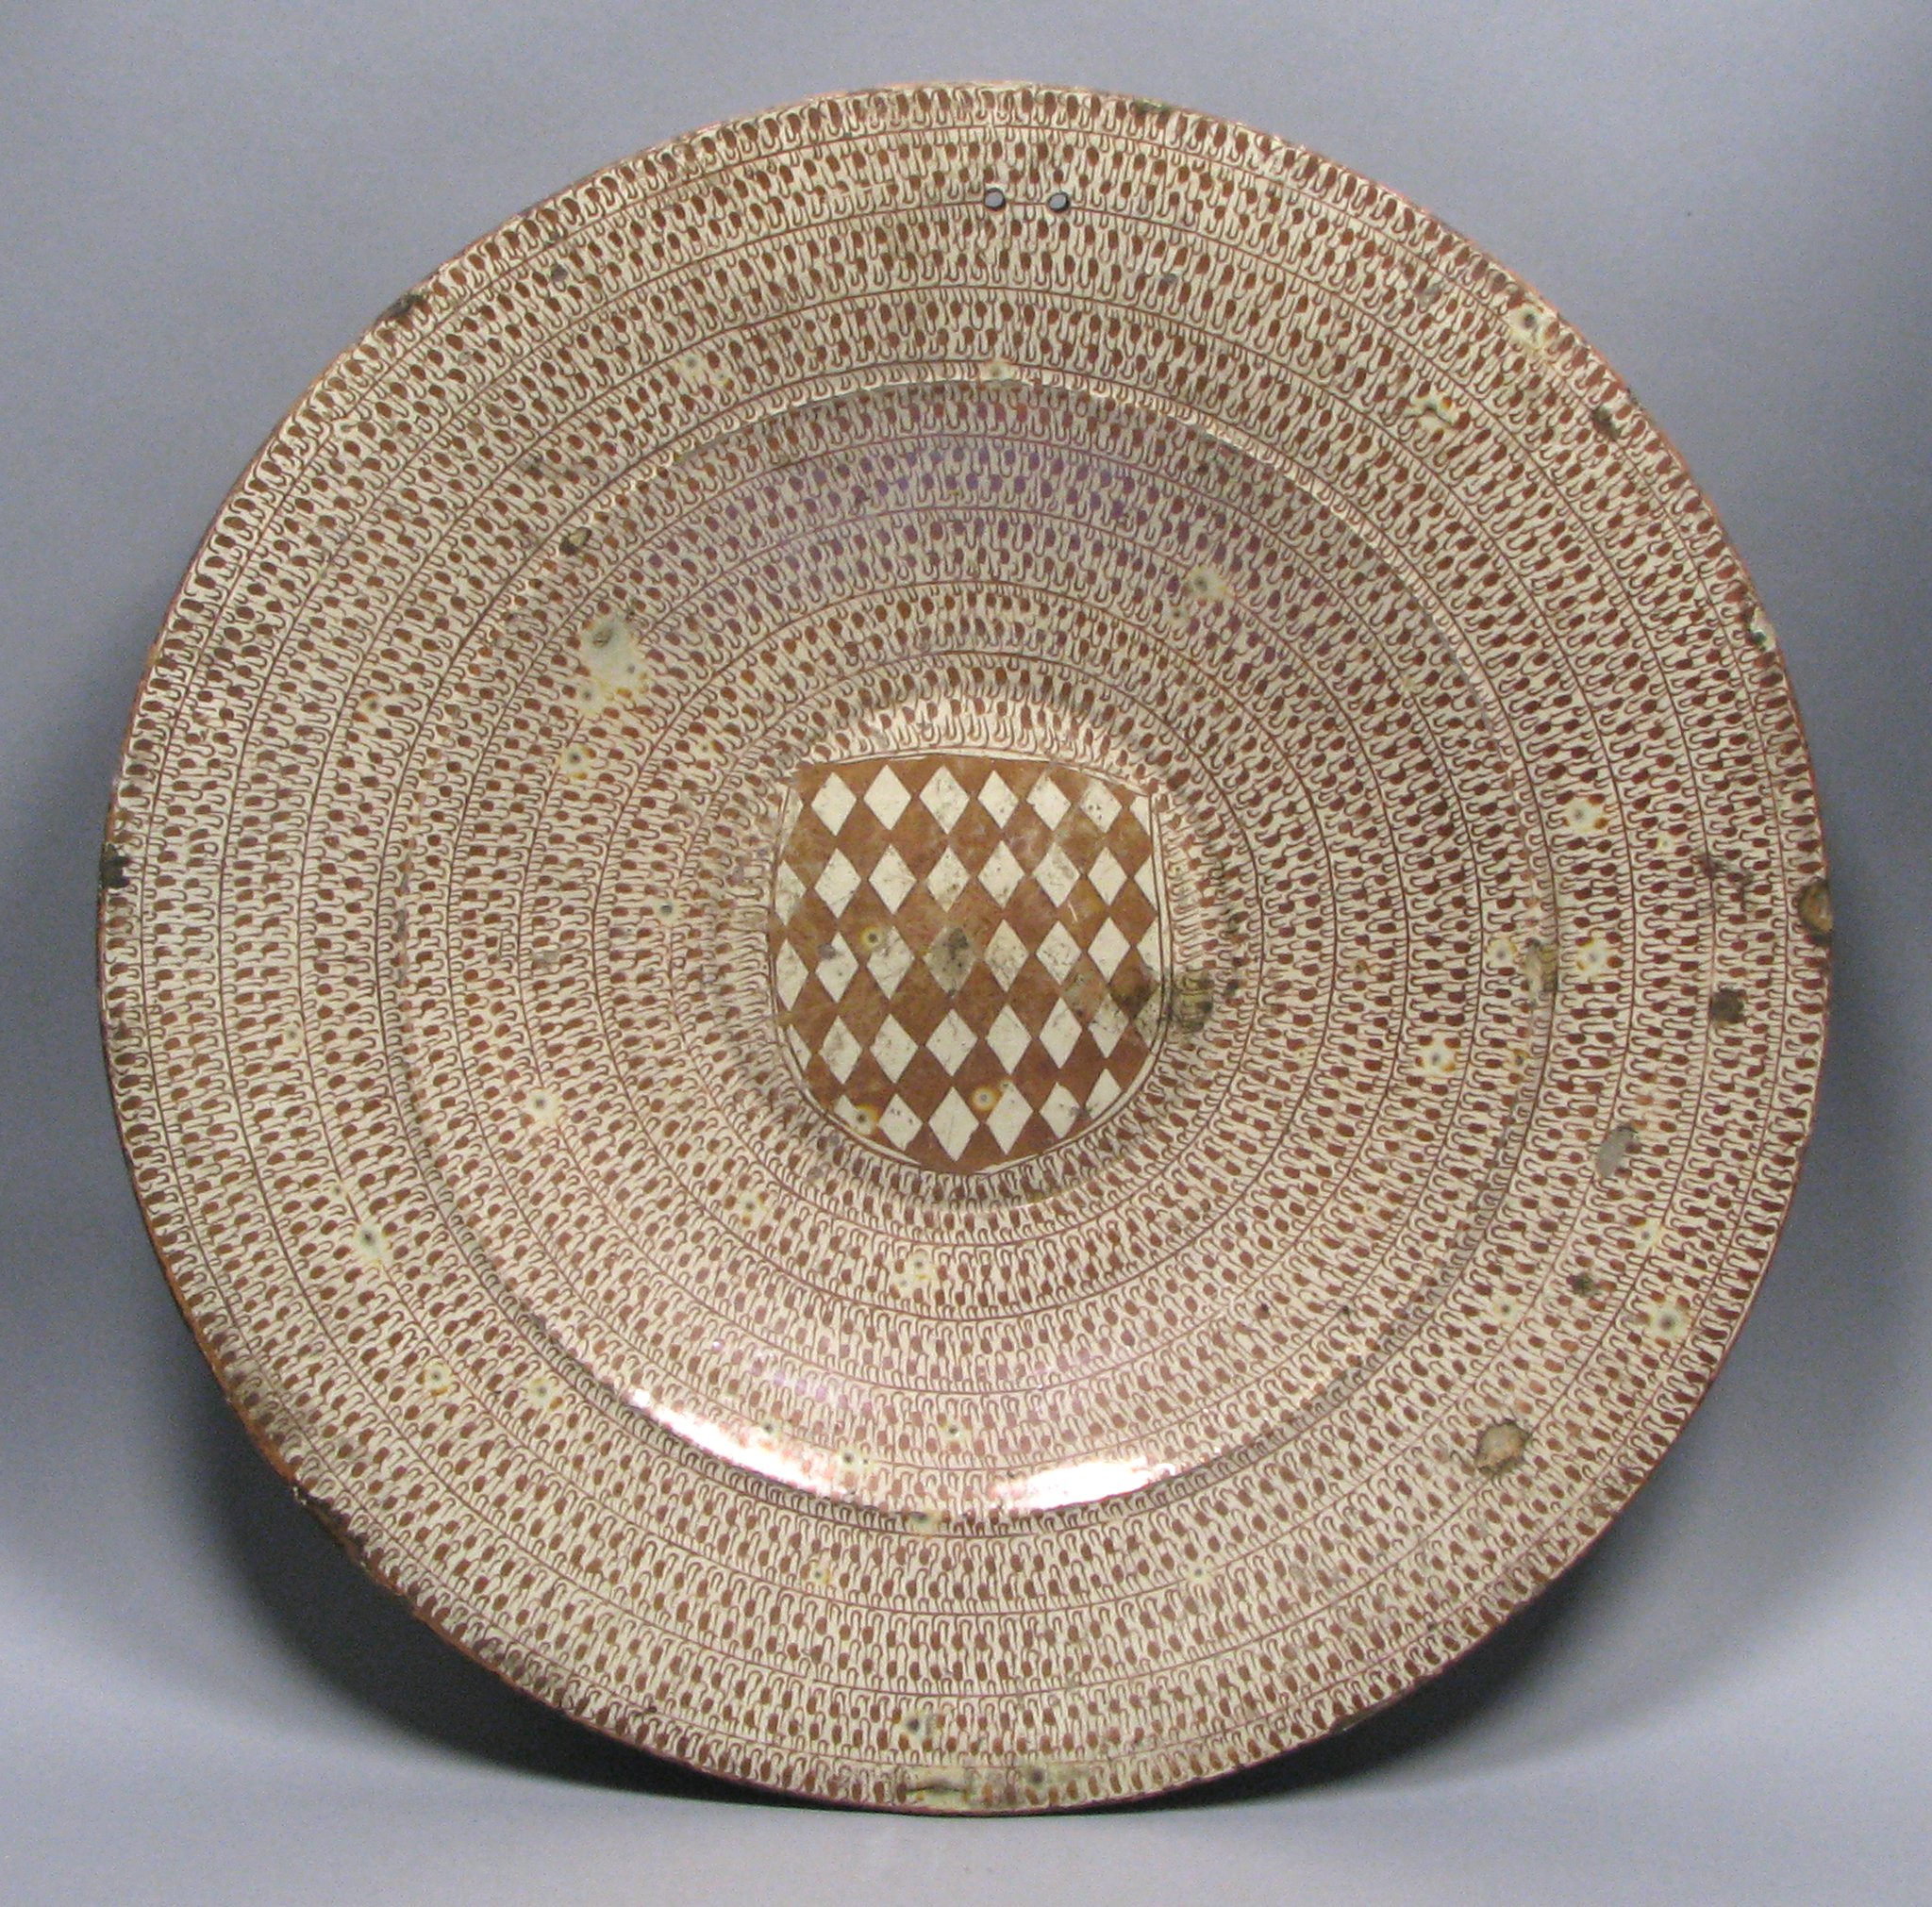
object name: dish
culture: spanish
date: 1467-1500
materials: earthenware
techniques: glazing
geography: spain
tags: coat of arms